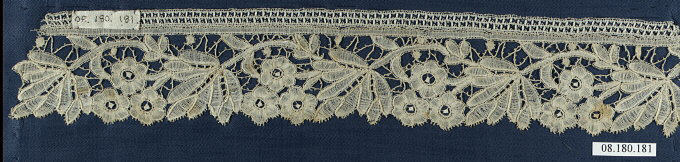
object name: piece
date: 1801-1900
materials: lace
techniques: lace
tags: flowers,leaves